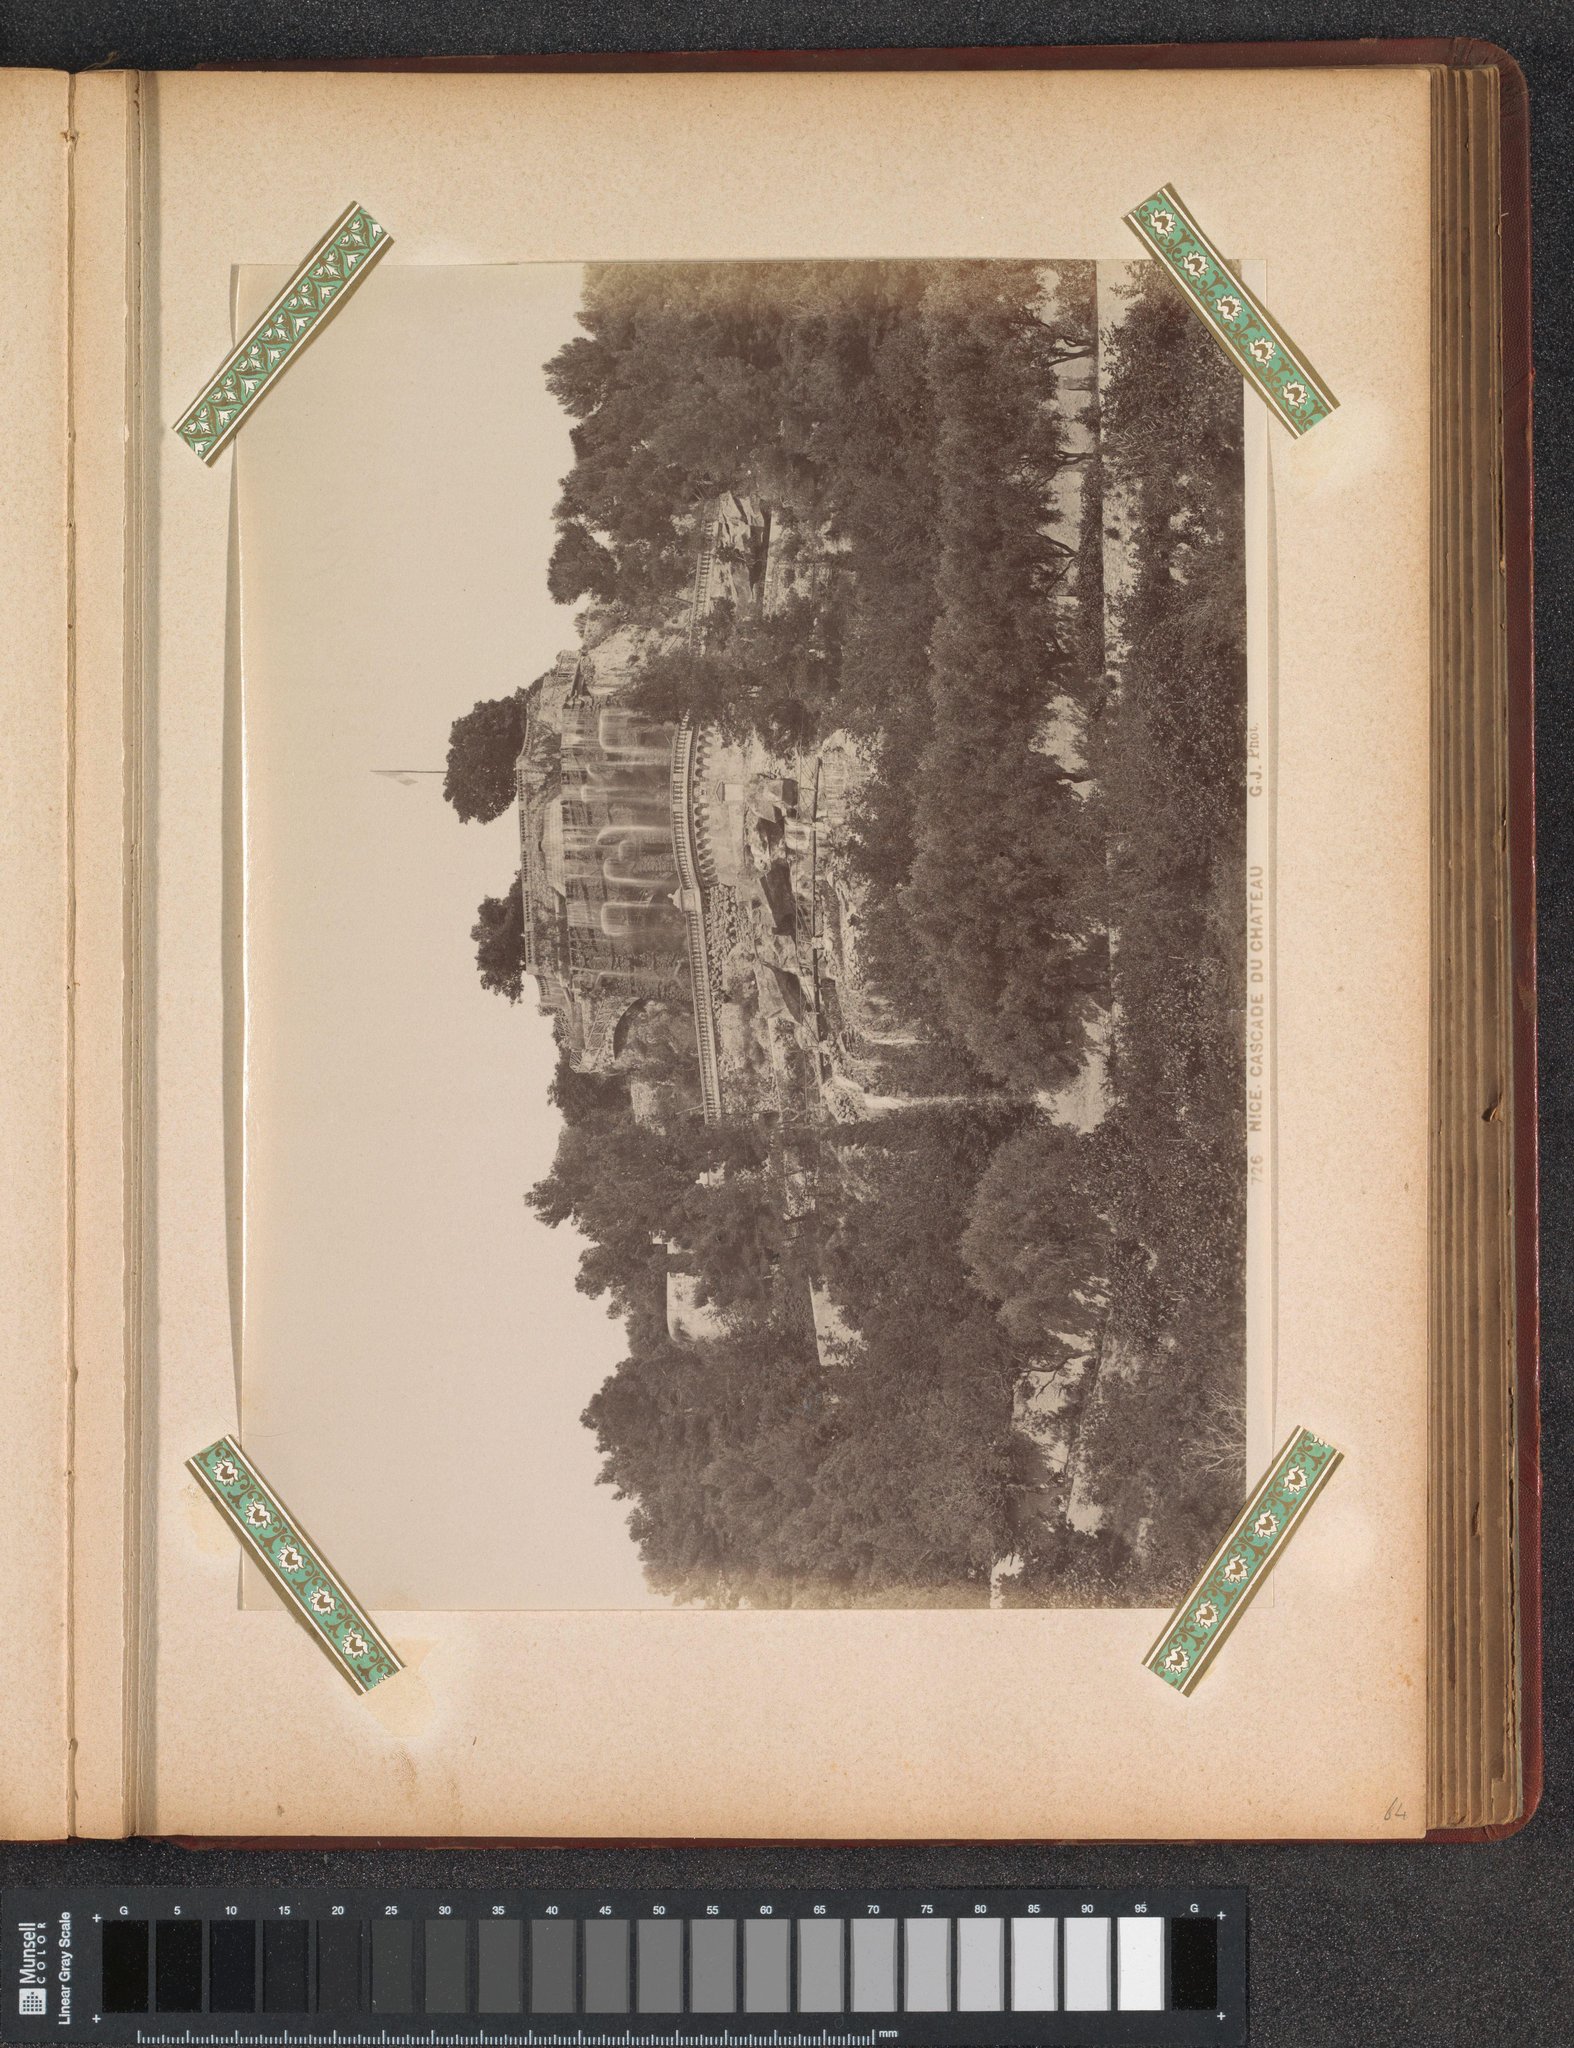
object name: album leaf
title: Nice. Cascade du Chateau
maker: jean gilletta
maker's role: fotograaf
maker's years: 1856-1933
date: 1870-1900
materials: paper, photographic support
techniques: albumen print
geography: nice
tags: castle, waterfall, garden cascade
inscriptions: negative number: ‘726’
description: Onderdeel van Reisalbum met foto's van bezienswaardigheden in Italië en Zuid-Frankrijk.